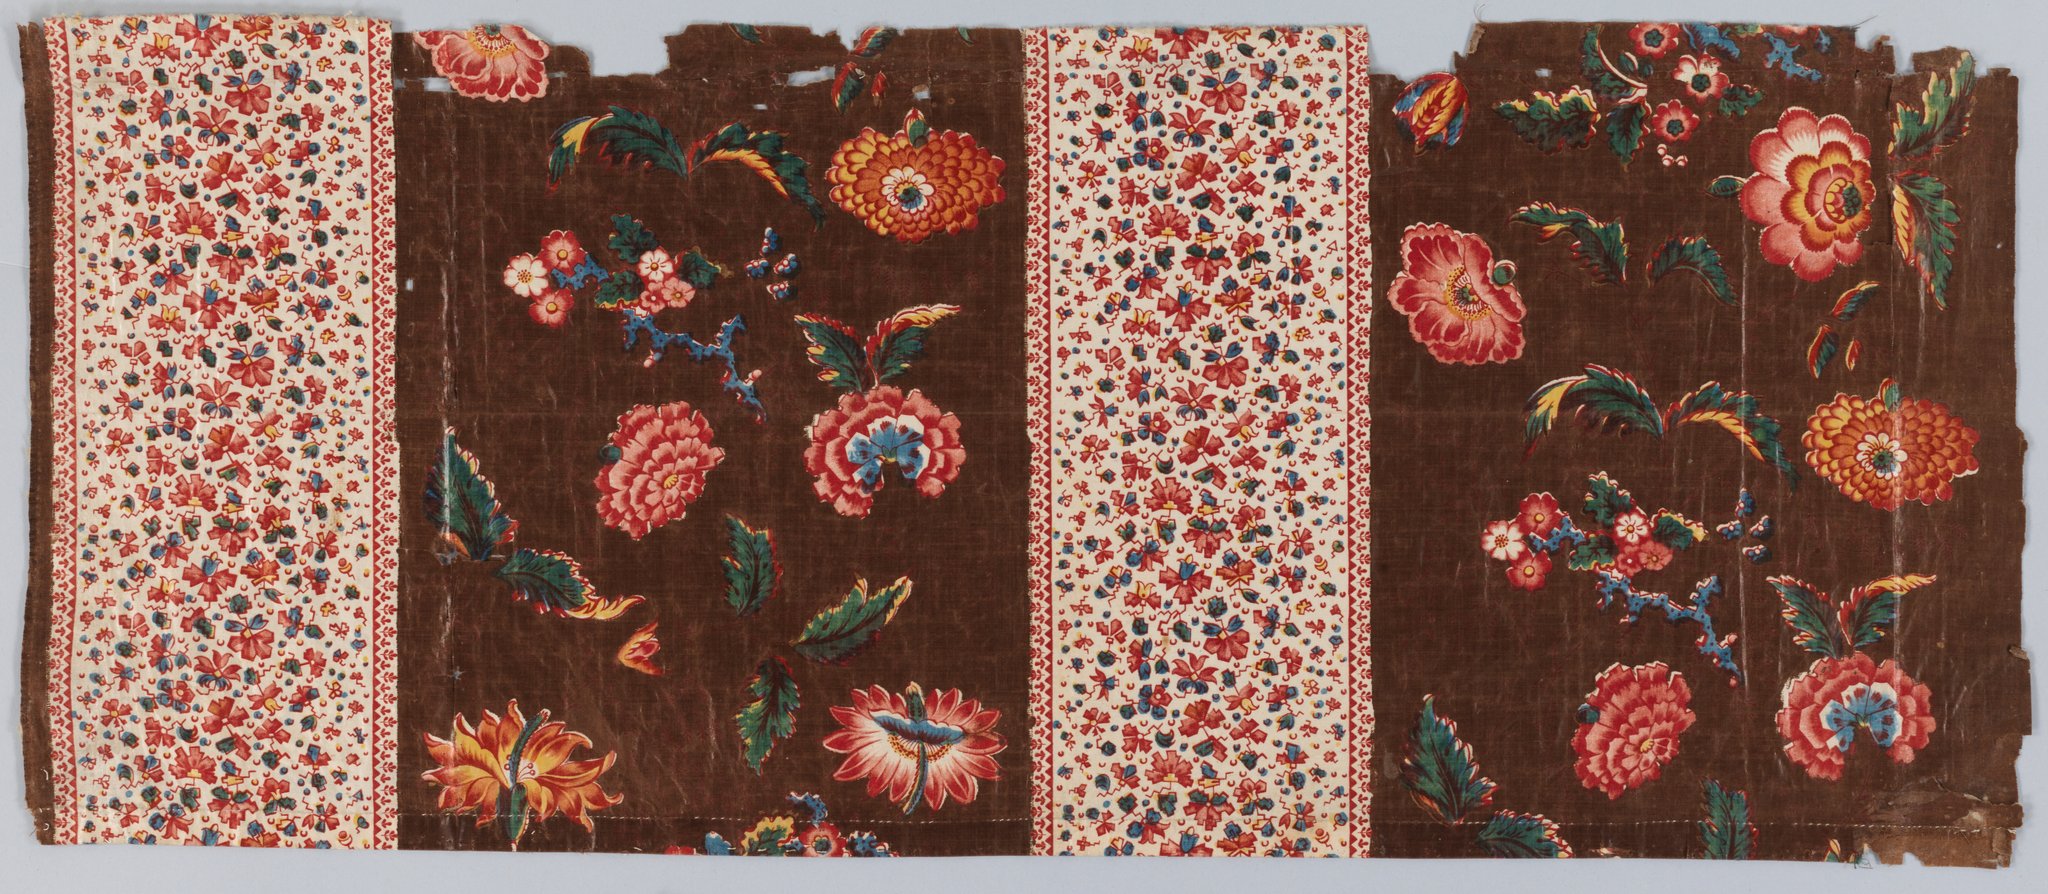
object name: piece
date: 1835-1840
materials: cotton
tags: flowers,leaves